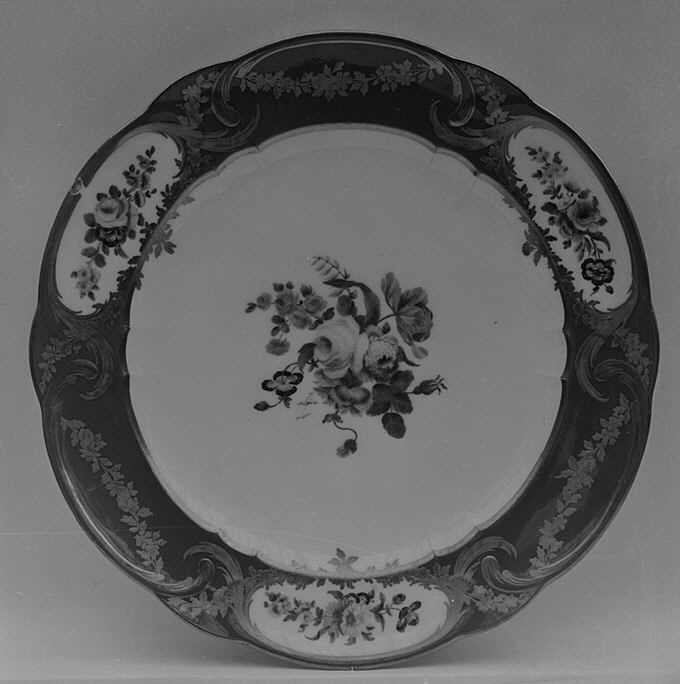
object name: plate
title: Plate (assiette à palmes) (1 of 102) (part of a service)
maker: sèvres manufactory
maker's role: manufactory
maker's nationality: french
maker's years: 1740-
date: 1772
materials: soft paste porcelain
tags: flowers